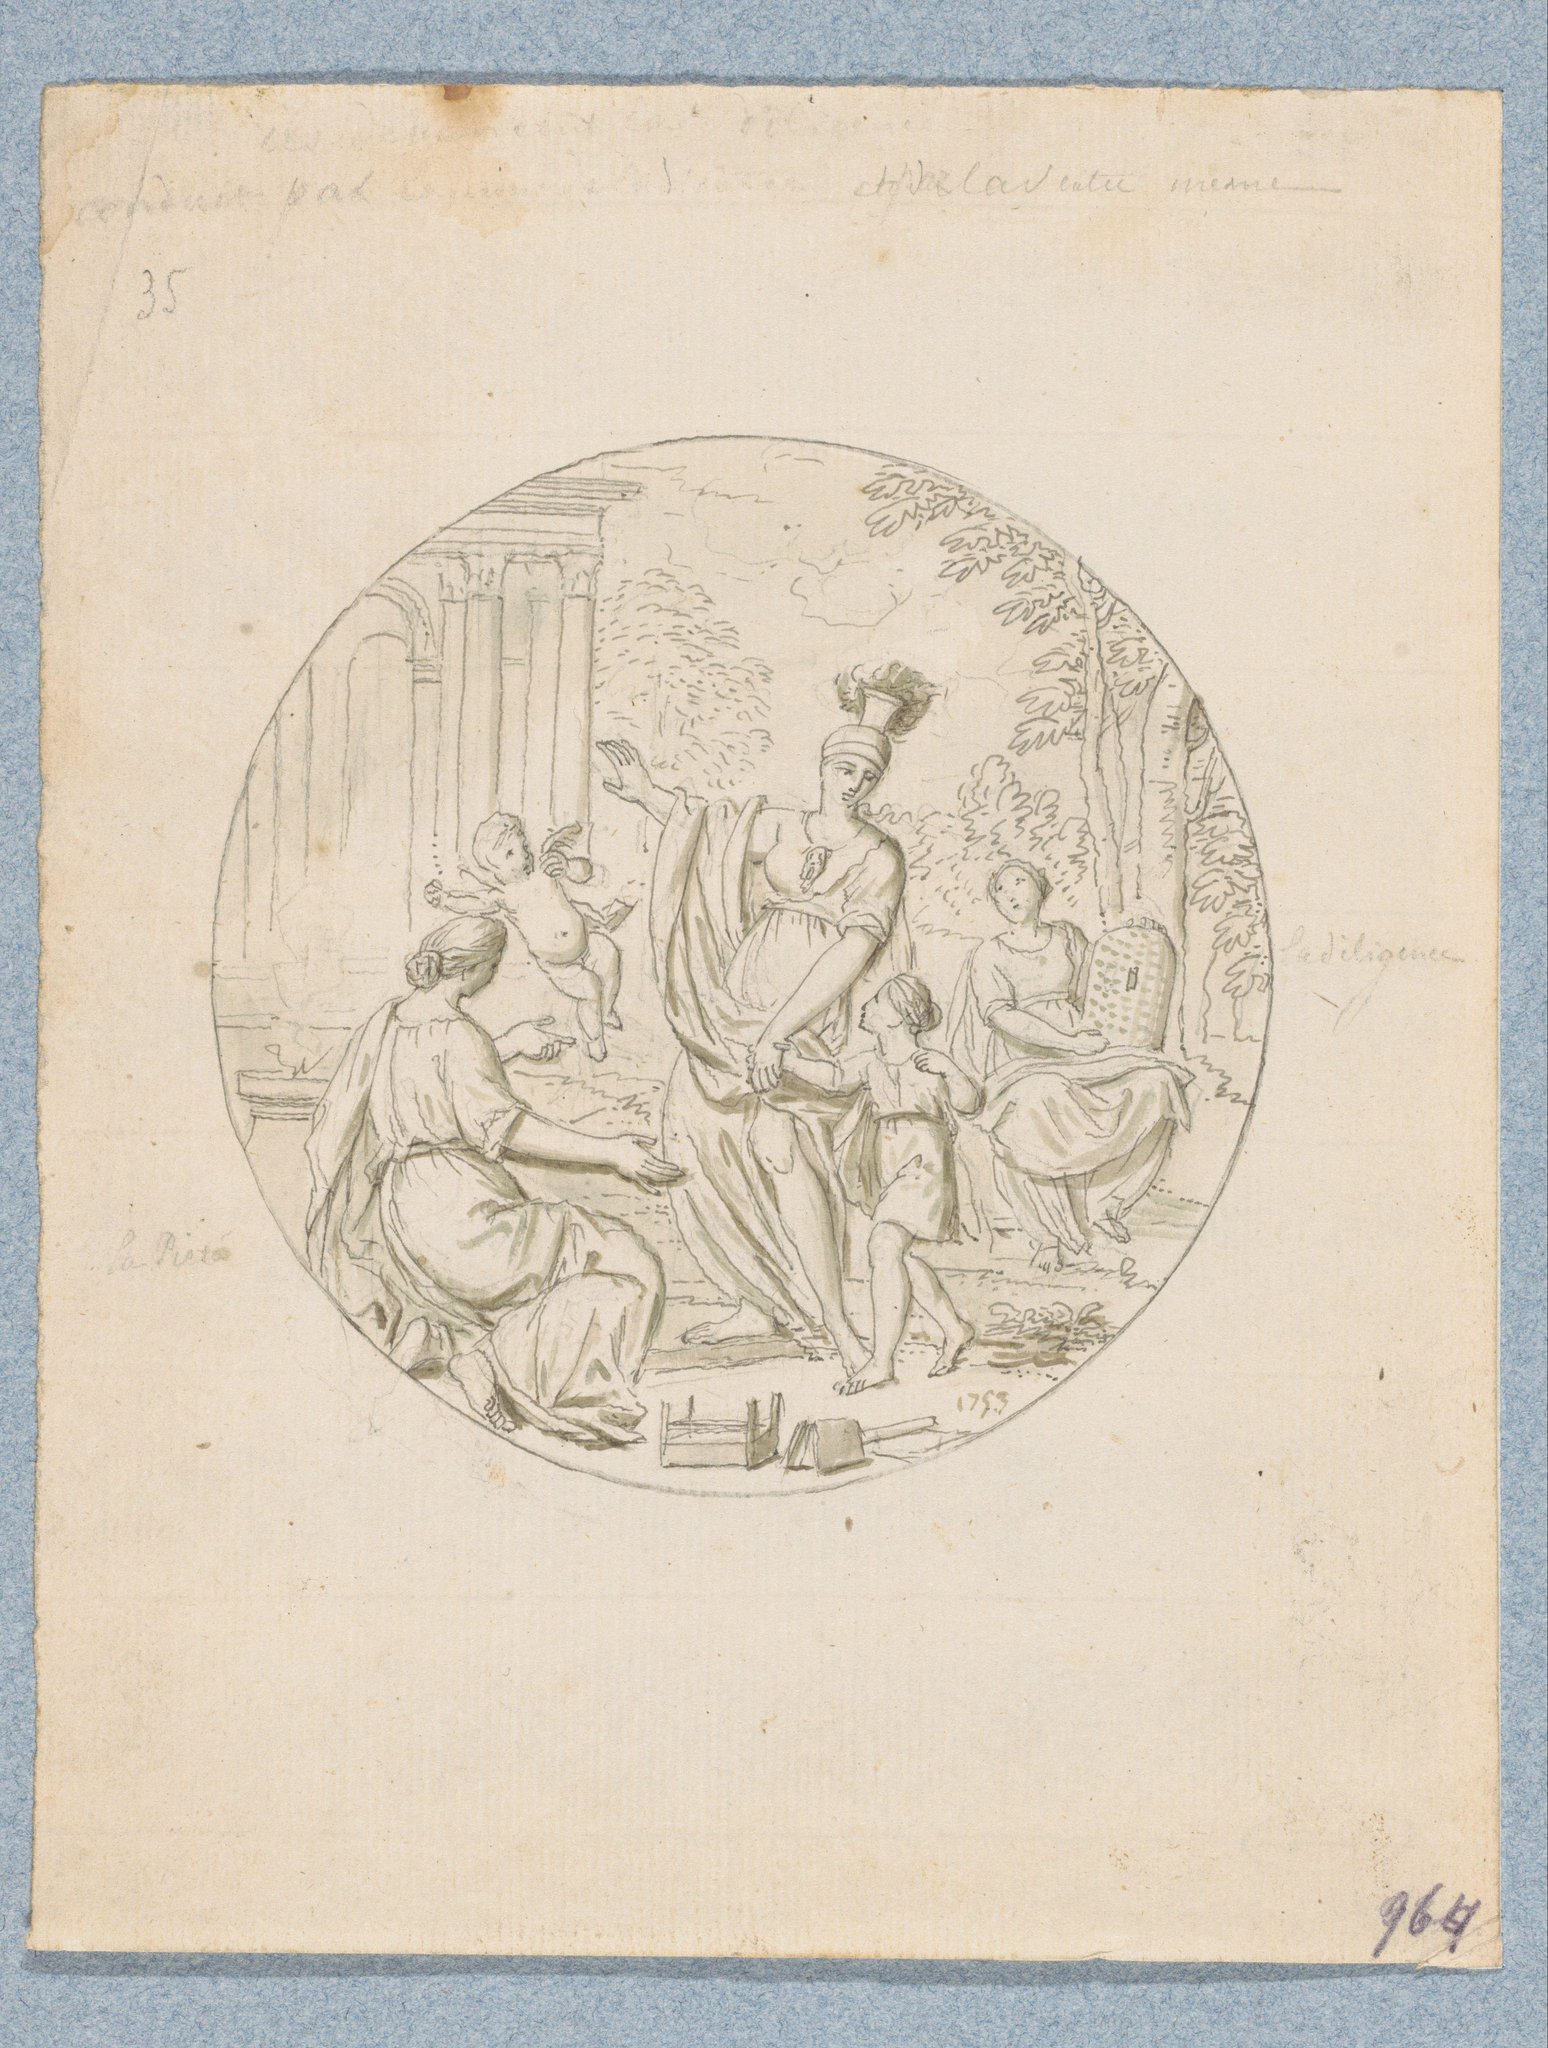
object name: drawing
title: Allegorie op de opvoeding (in doos met 43 tekeningen)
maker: louis fabritius dubourg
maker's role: draughtsman, print maker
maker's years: 1693-1775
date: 1753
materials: ink, paper, pencil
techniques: brush, pen